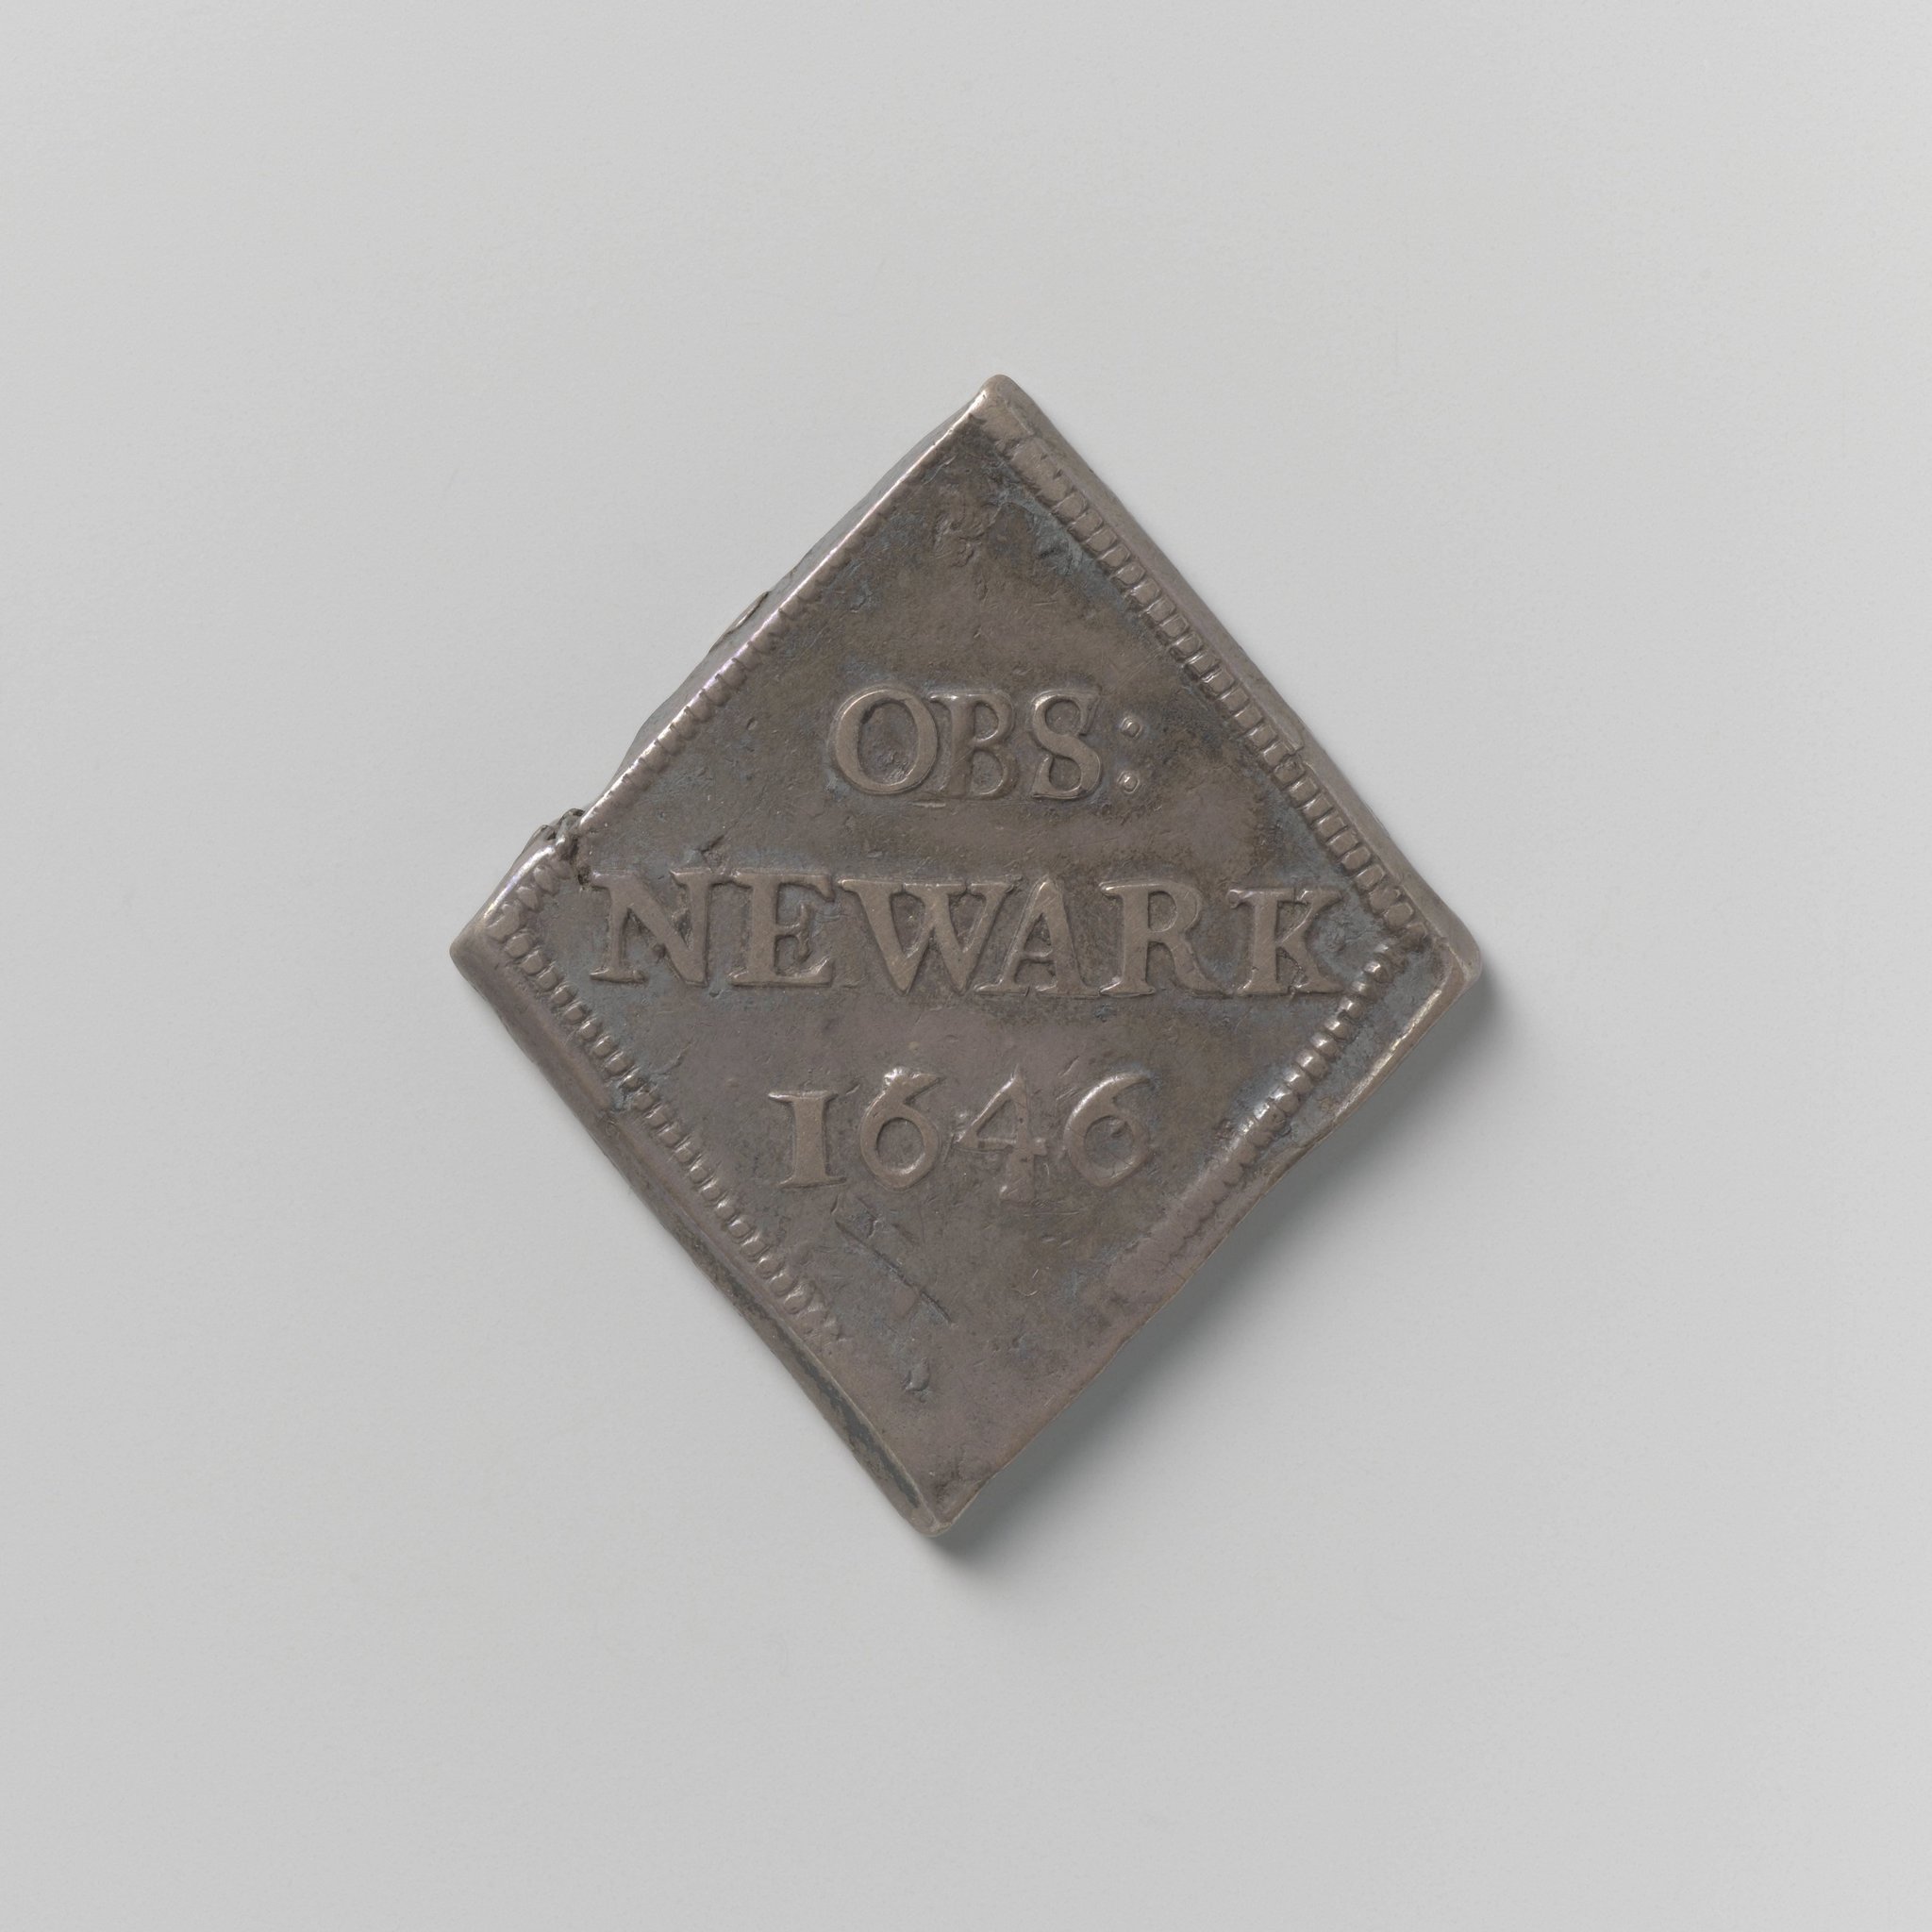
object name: siege coin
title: halve crown; dertig pence, noodmunt uit Newark-on-Trent, geslagen tijdens het beleg door parlementariërs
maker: Anonymous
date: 1646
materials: silver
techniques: striking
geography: newark-on-trent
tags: london, karel i (koning van engeland)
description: ruitvormige noodmunt. Voorzijde: kroon tussen letters C en R boven Romeinse cijfer XXX. Keerzijde: opschrift